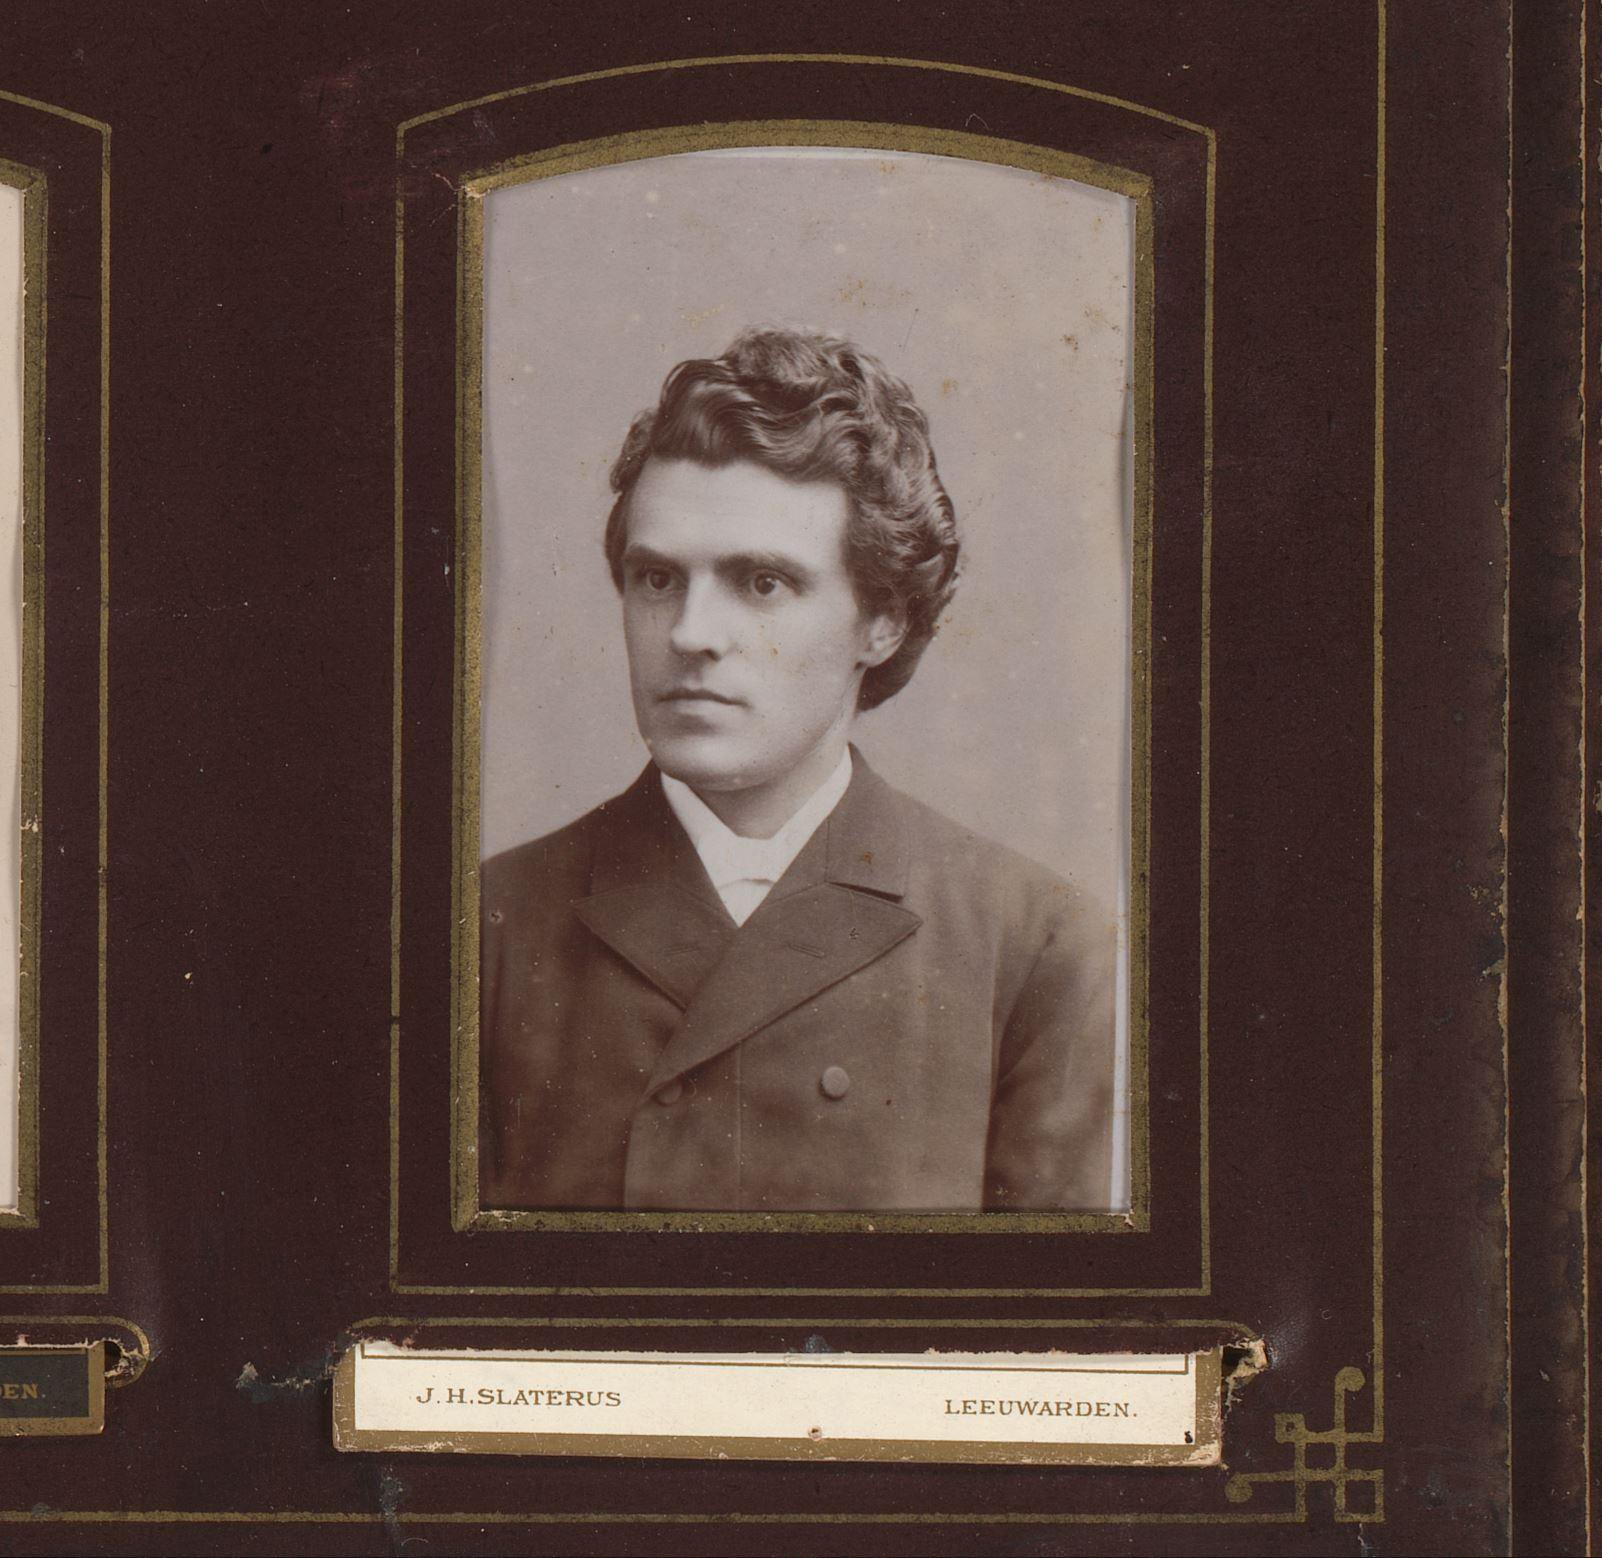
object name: album leaf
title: Portret van een jonge man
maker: idanus hendrikus slaterus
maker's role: fotograaf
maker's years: 1846-1921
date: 1873-1909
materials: cardboard, photographic support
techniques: gelatin silver print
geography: leeuwarden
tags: historical persons, youth, adolescent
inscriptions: inscription: ‘Photographie/ Instantanée/ I. H. Slaterus/ Leeuwarden/ Weerd.’